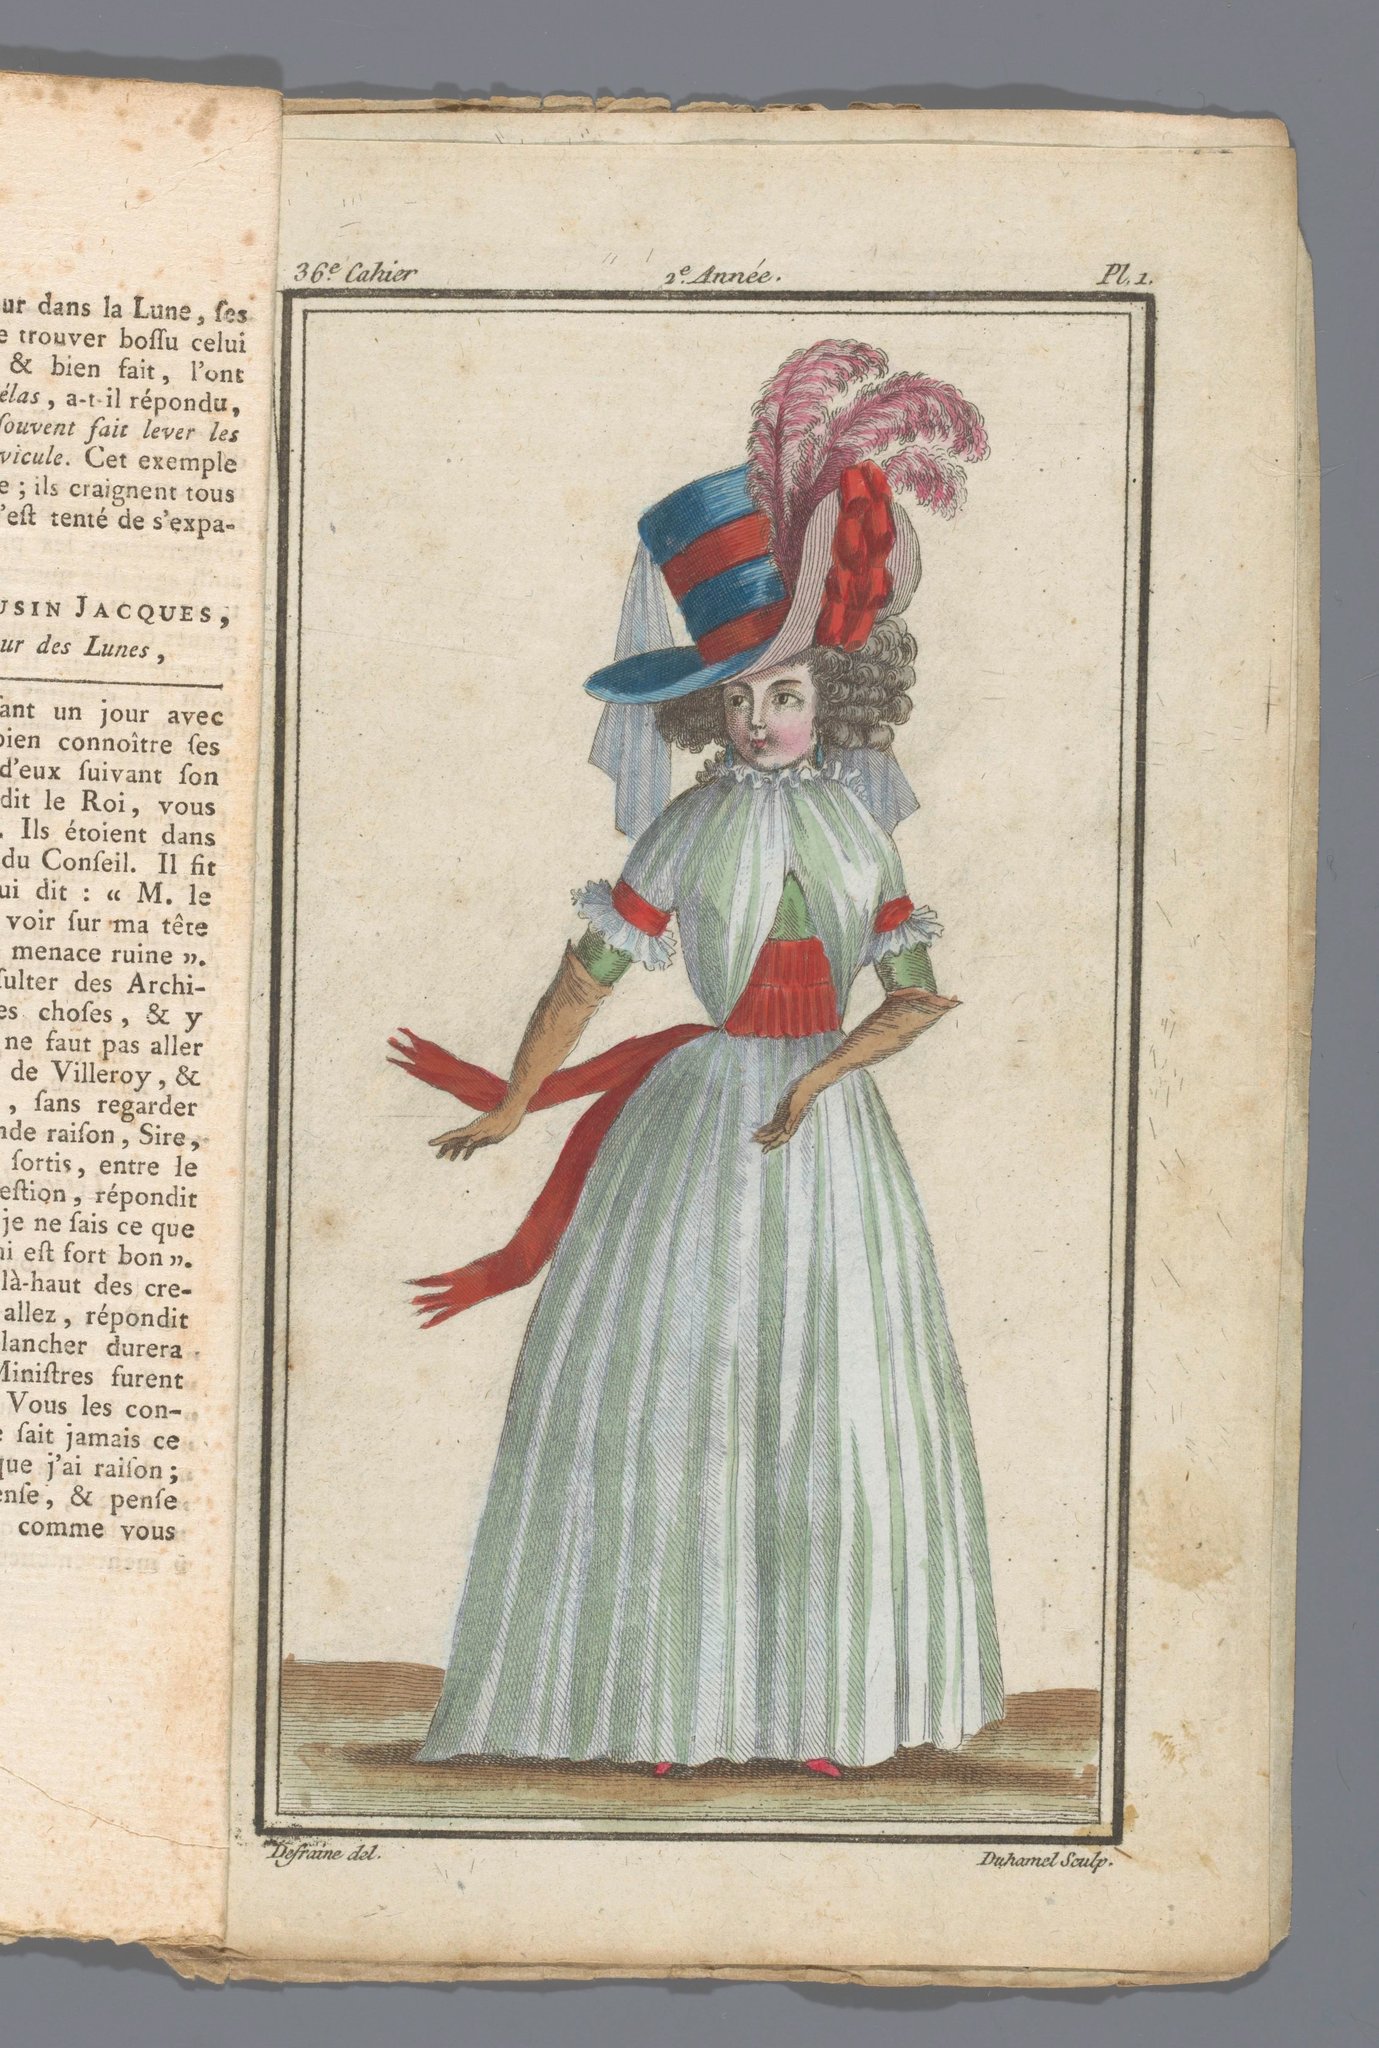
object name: fashion print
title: Magasin des Modes Nouvelles Françaises et Anglaises, 10 novembre 1787, 36e cahier, 2e année, Pl. 1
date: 1787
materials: paper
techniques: engraving, hand coloring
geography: paris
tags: gloves, mittens (long gloves) (+ women's clothes), border, ribbon, braid (+ women's clothes), fashion plates, head-gear: hat (+ women's clothes), dress, gown (+ women's clothes)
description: Staande vrouw gekleed in een 'chemise à la vestale' van witte mousseline, een breed rood lint als ceintuur. Op het hoofd een 'grand chapeau à la Tarare'. De prent maakt deel uit van het 36e Cahier, 2e année, uit de serie Magasin des Modes Nouvelles Françaises et Anglaises. De serie bestaat uit 172 modeprenten, uitgegeven door Buisson, Parijs, 20 novembre 1786 - 21 décembre 1789.